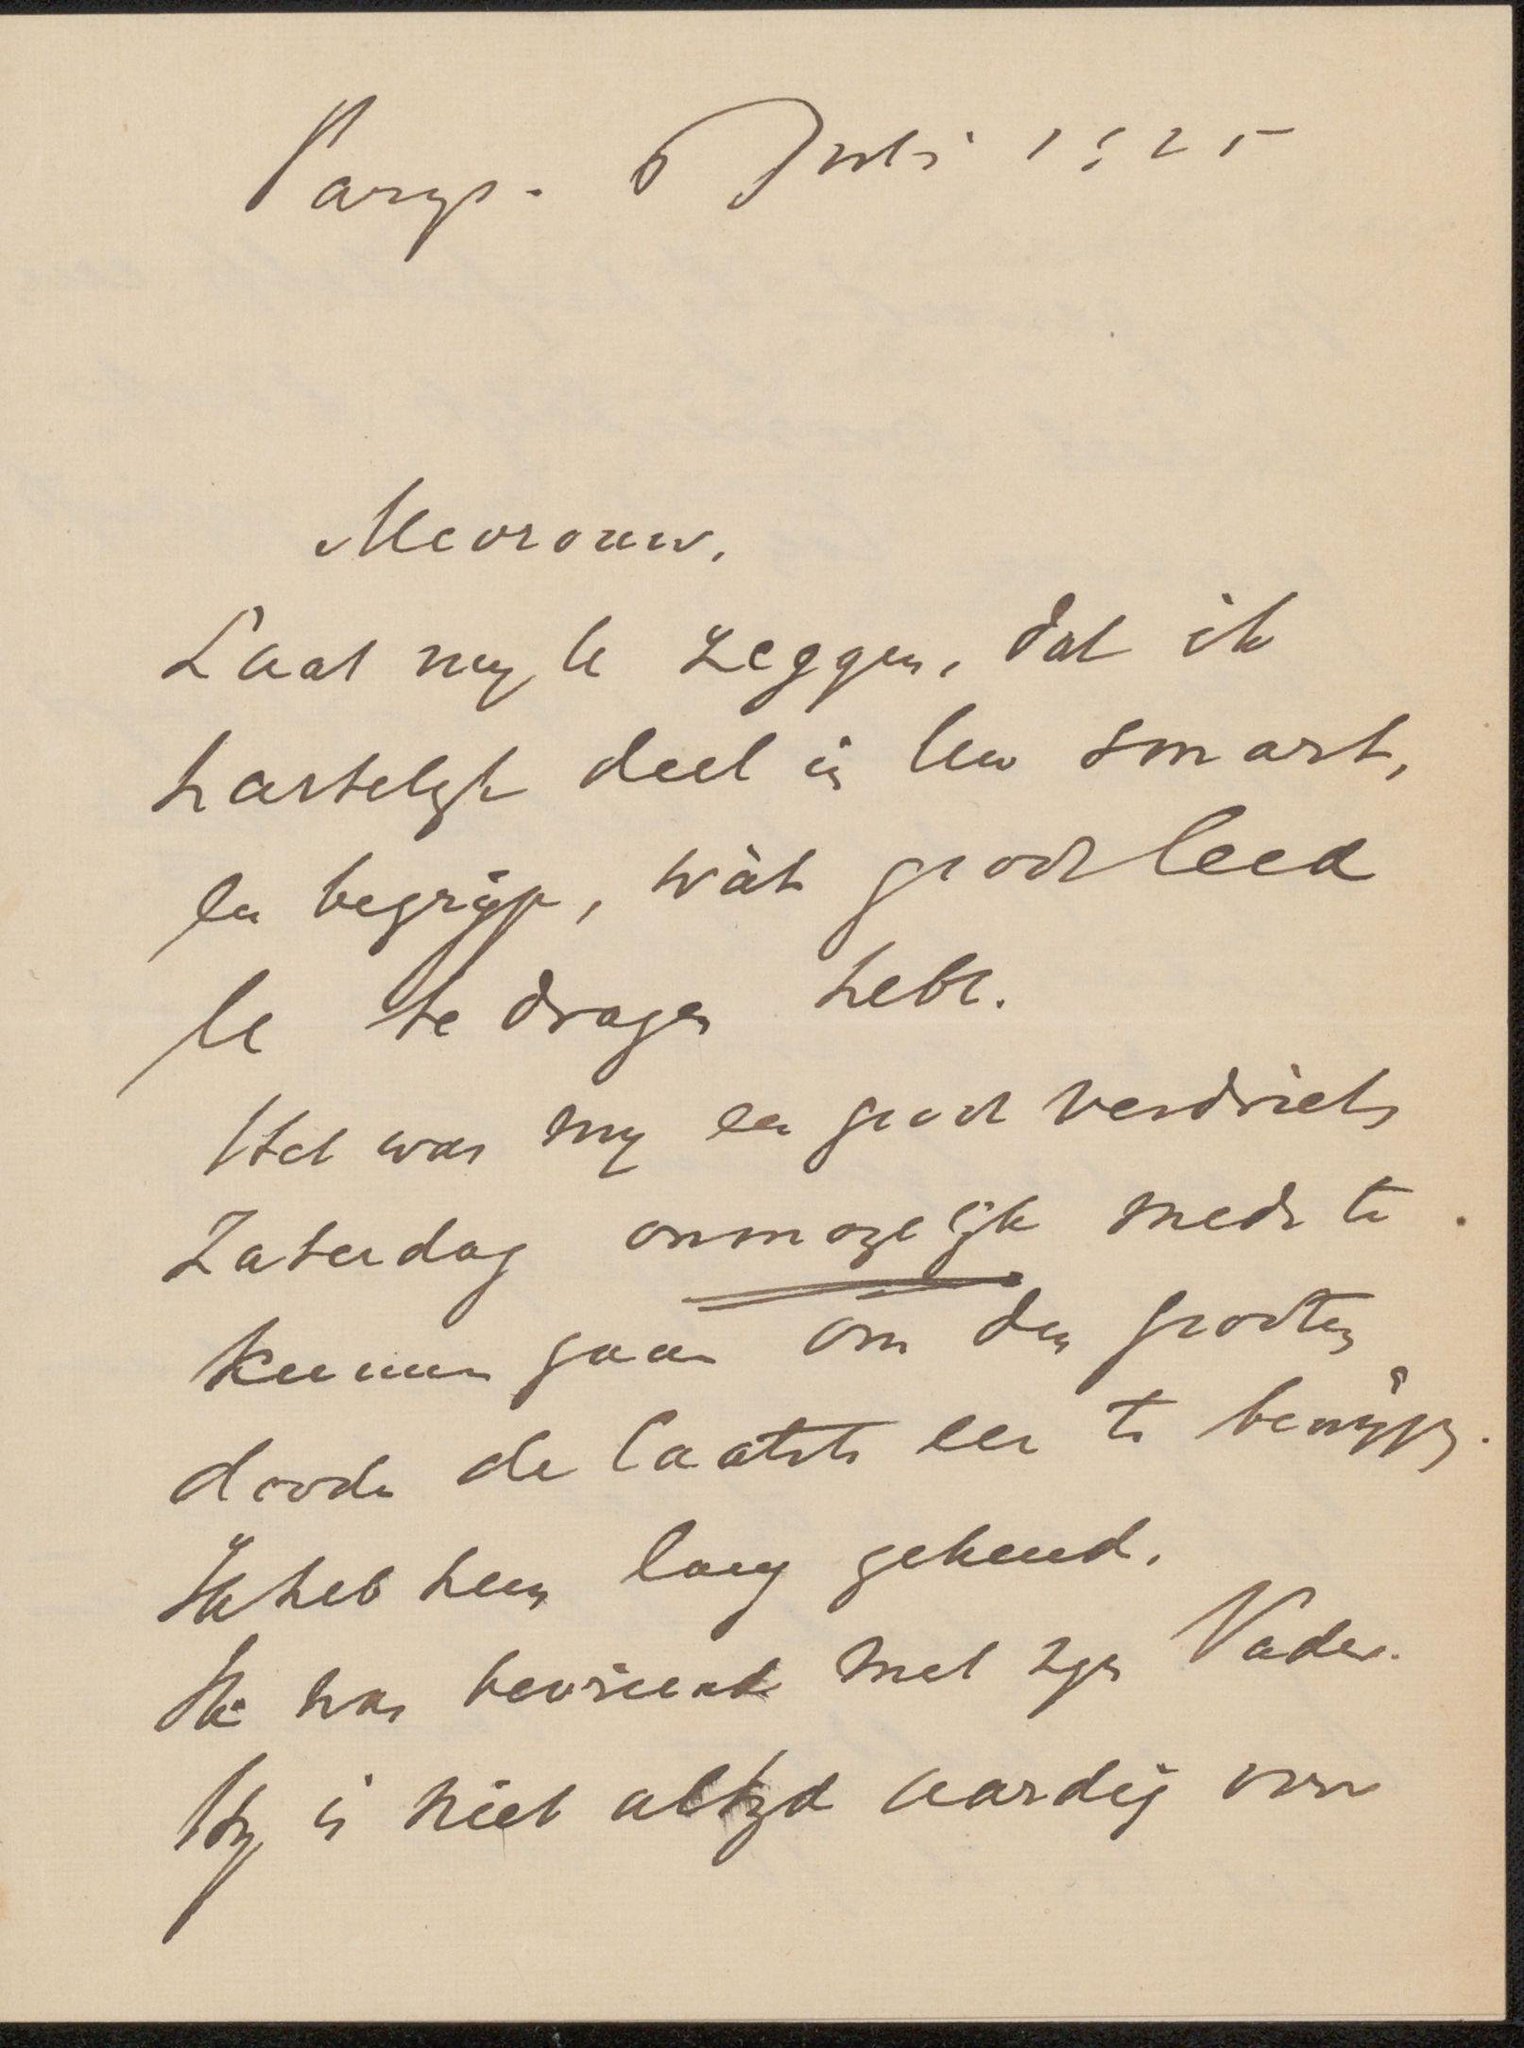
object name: letter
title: Brief aan Anna Dorothea Dirks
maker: abraham bredius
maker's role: kunsthistoricus, museumdirecteur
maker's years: 1855-1946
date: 1925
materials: ink, paper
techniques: pen, writing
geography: paris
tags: dordrecht, amsterdam, painter, print maker, draughtsman, designer, jan veth, artist, anna dorothea dirks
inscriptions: collector's mark: ‘RPK’